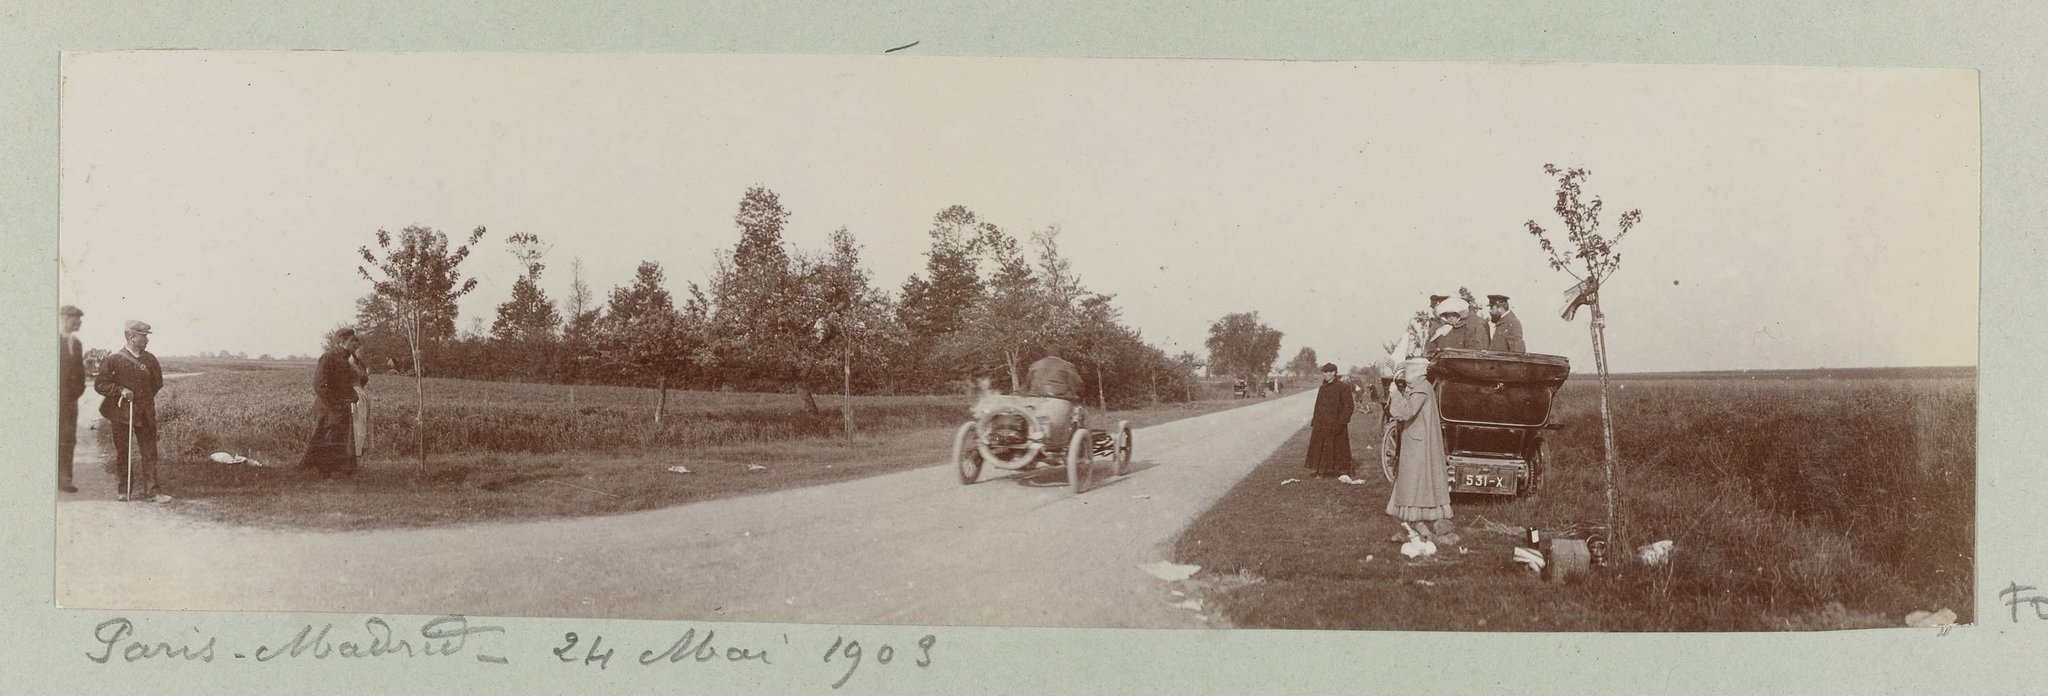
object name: photograph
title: Toeschouwers en deelnemer bij de automobielrace Parijs-Madrid, vermoedelijk op een landweg in Frankrijk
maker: delizy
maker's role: manufacturer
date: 1903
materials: paper, photographic support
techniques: gelatin silver print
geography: france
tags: motorcar racing, road, path, automobile, france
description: Onderdeel van Fotoalbum van een Franse amateurfotograaf met opnames van uitstapjes in Frankrijk, Spanje, België, Luxemburg en Nederland, de eerste automobielen en autoraces.